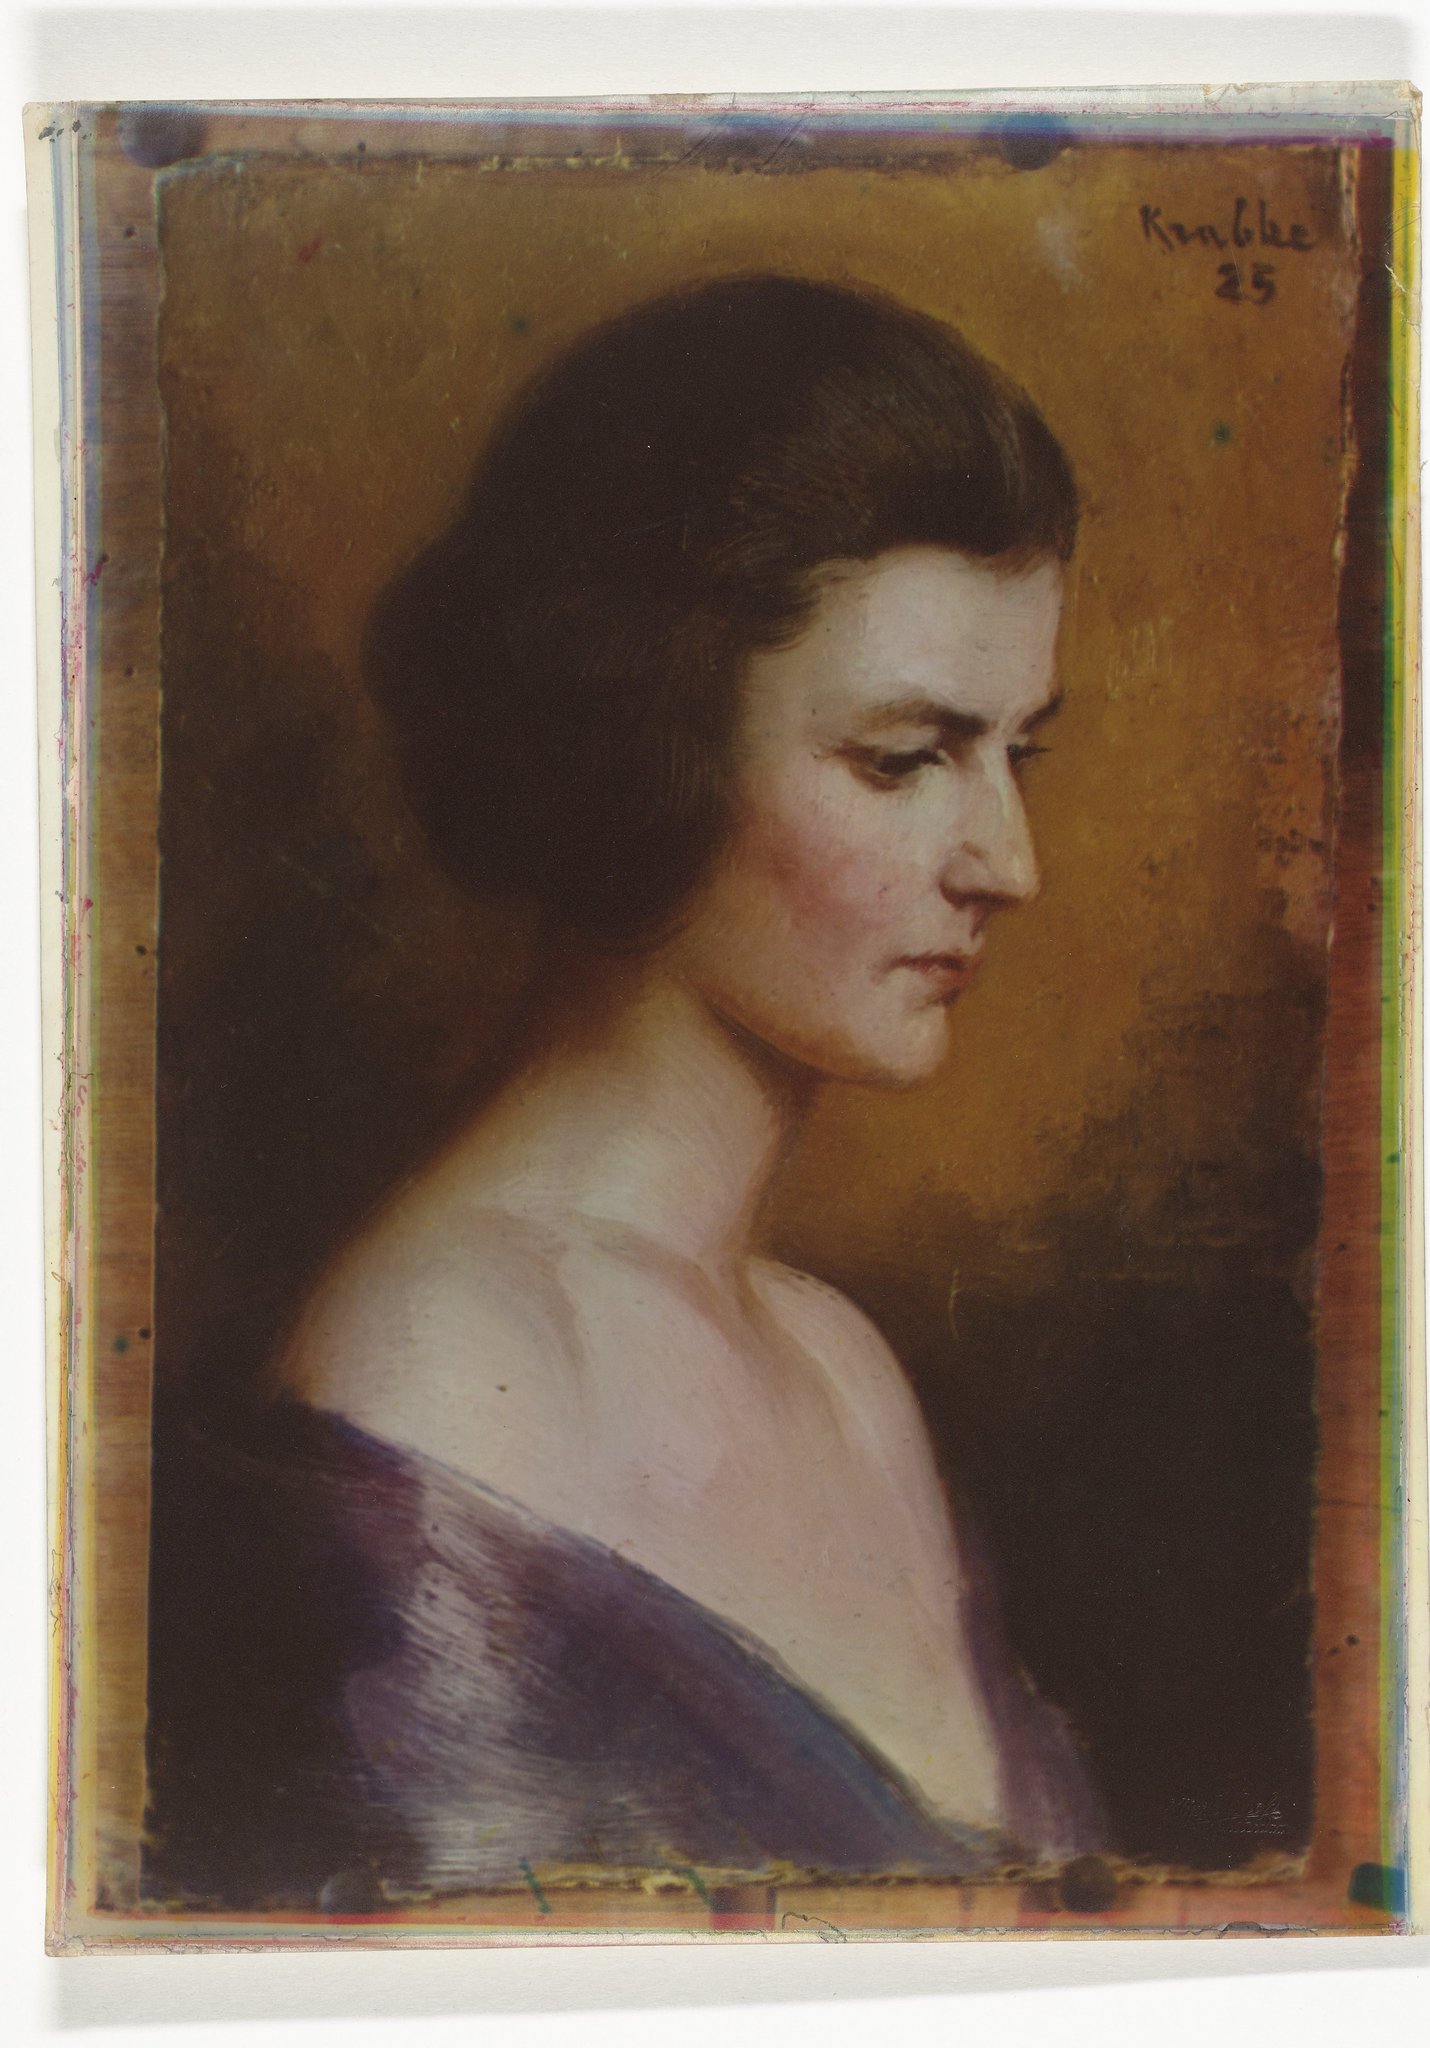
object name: photograph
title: Reproductie van vrouwenbuste door schilder Krabbé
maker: jacob merkelbach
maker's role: fotograaf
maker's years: 1877-1942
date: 1920-1930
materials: photographic support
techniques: jos-pé print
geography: amsterdam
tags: historical persons not known by name - bb - woman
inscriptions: annotation: ‘foto Merkelbach Jos Pe colorrepro schilder Krabbé’